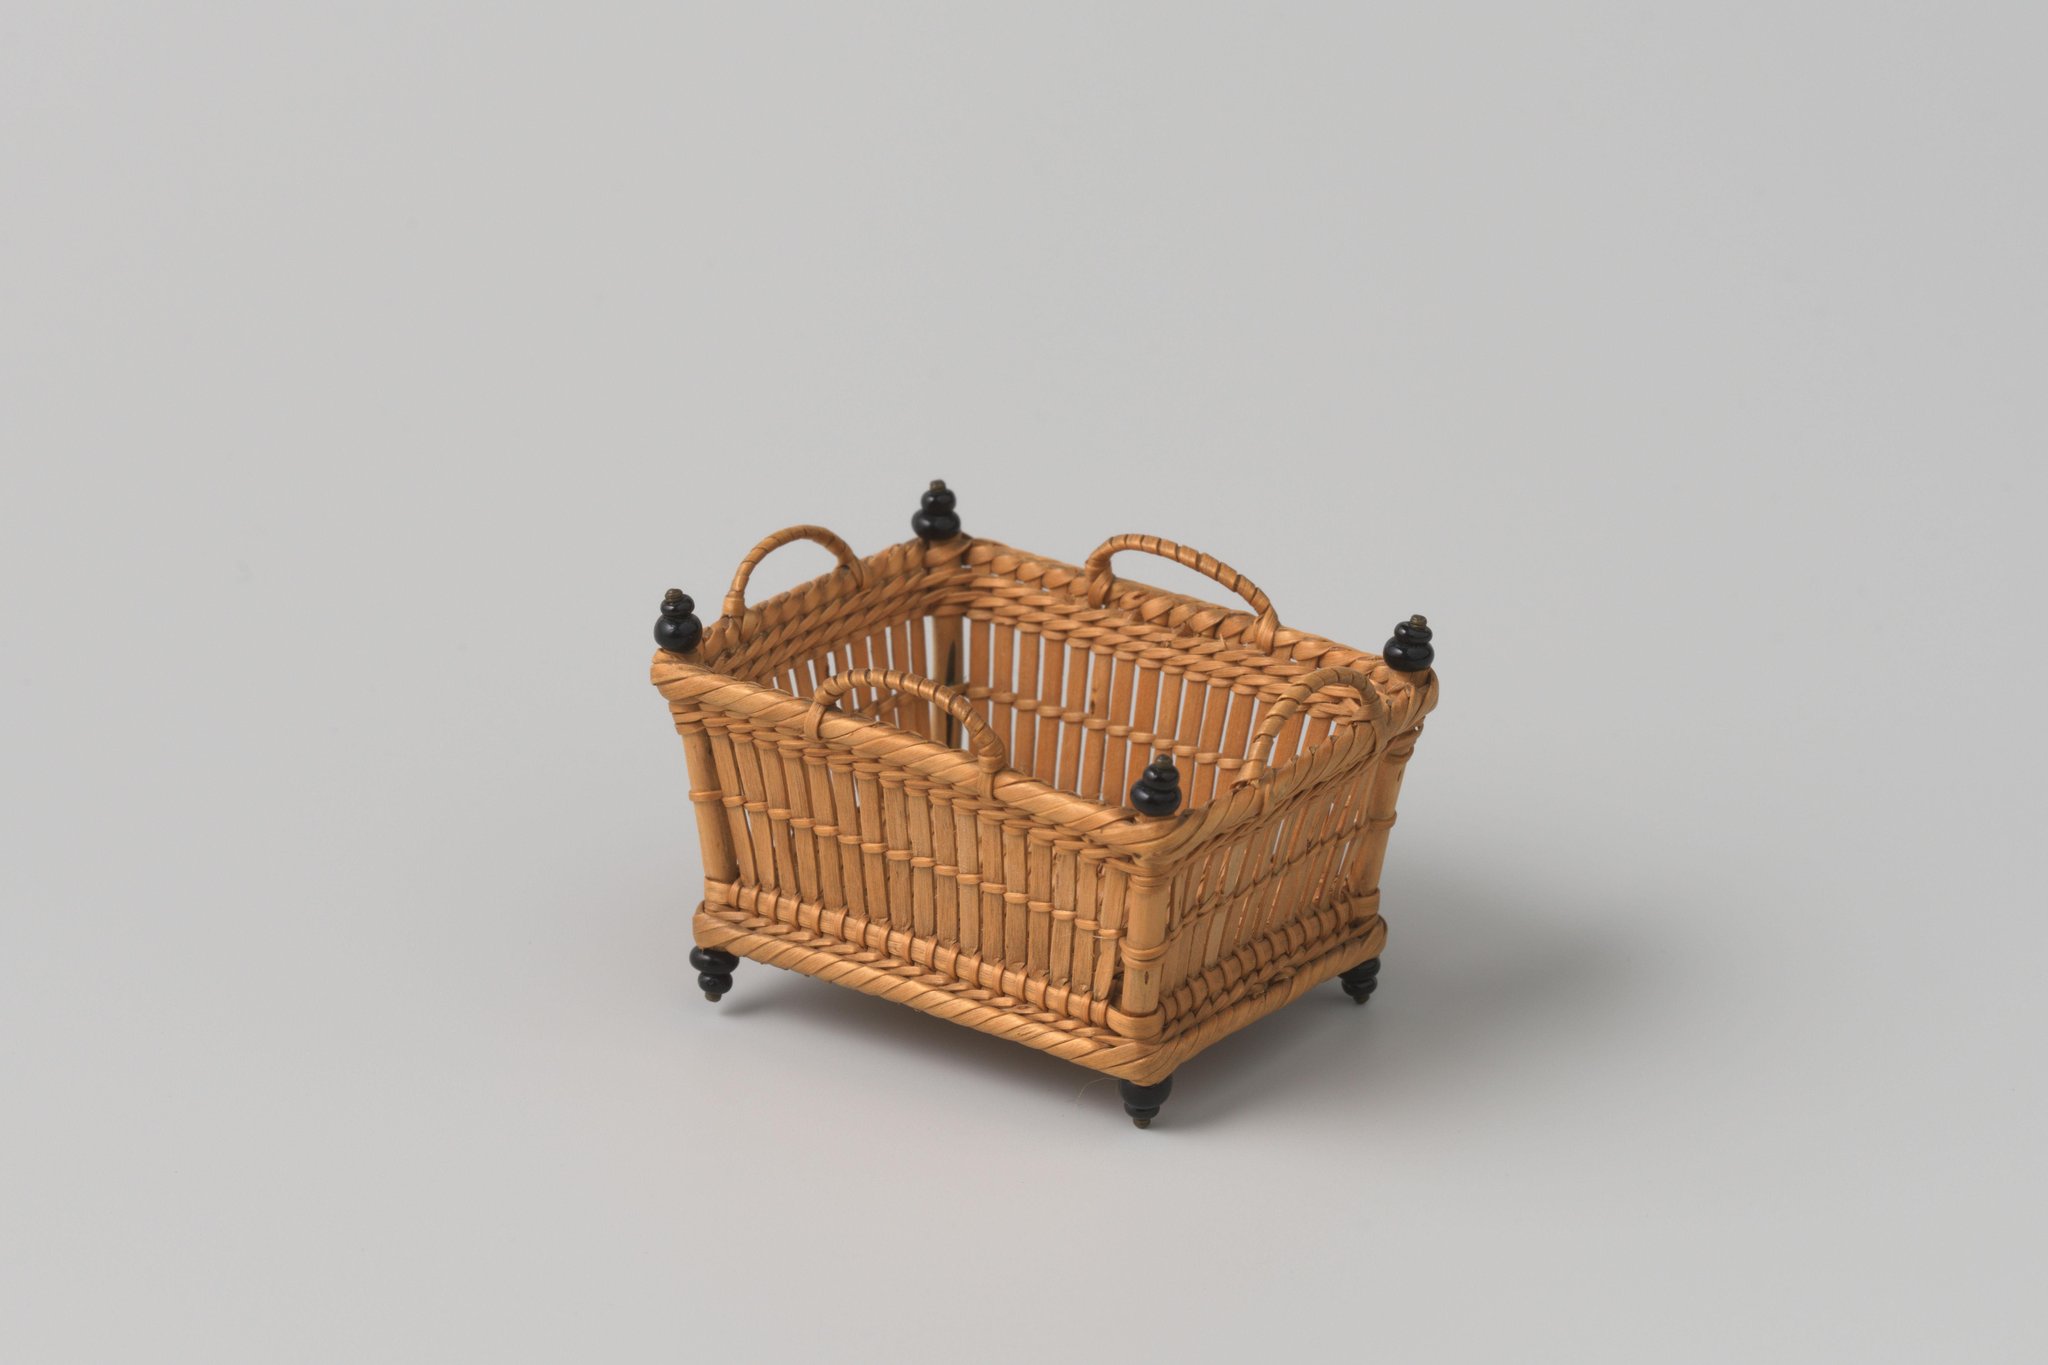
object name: miniature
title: Luiermand van gevlochten wilgenteen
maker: Anonymous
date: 1676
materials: glass, metal, plant material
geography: halle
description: Luiermand van gespleten wilgenteen fijnscheenwerk, rechthoekige hoge mand met open wanden, voorzien van vier handvatten. De mand rust op vier bolpoten en is versierd met vier knoppen op de stijlen. De bolpoten en de knoppen zijn vervaardigd van zwart glazen kralen op een speld geregen.